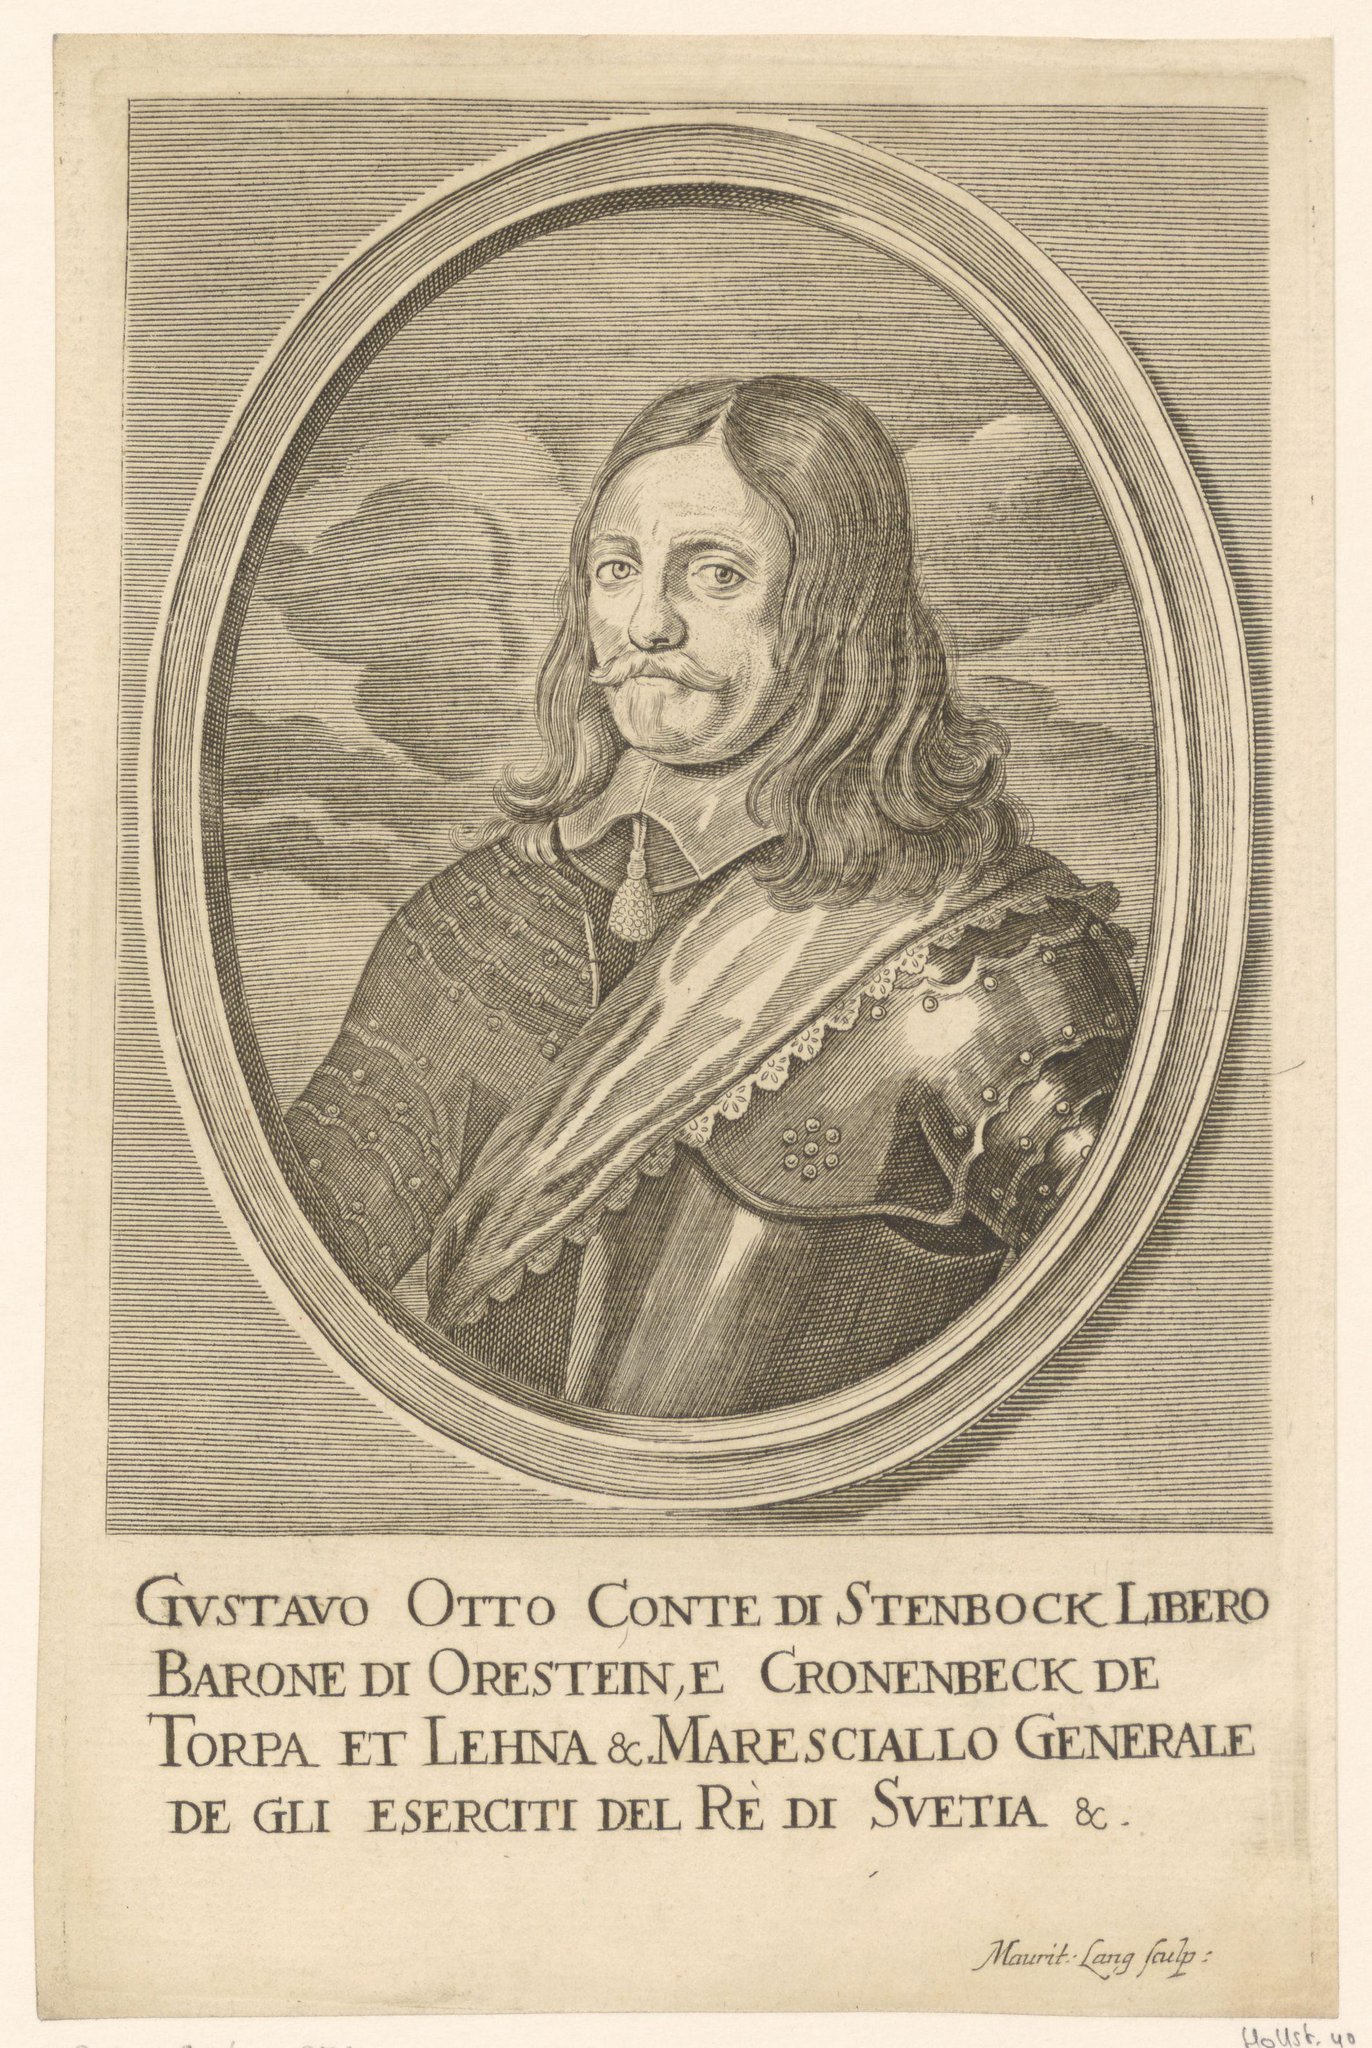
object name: print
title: Portret van Gustav Otto Steenbock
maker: moritz lang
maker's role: draughtsman, print maker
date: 1649-1670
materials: paper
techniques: engraving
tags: historical persons, officer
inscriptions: collector's mark: Lugt 2228